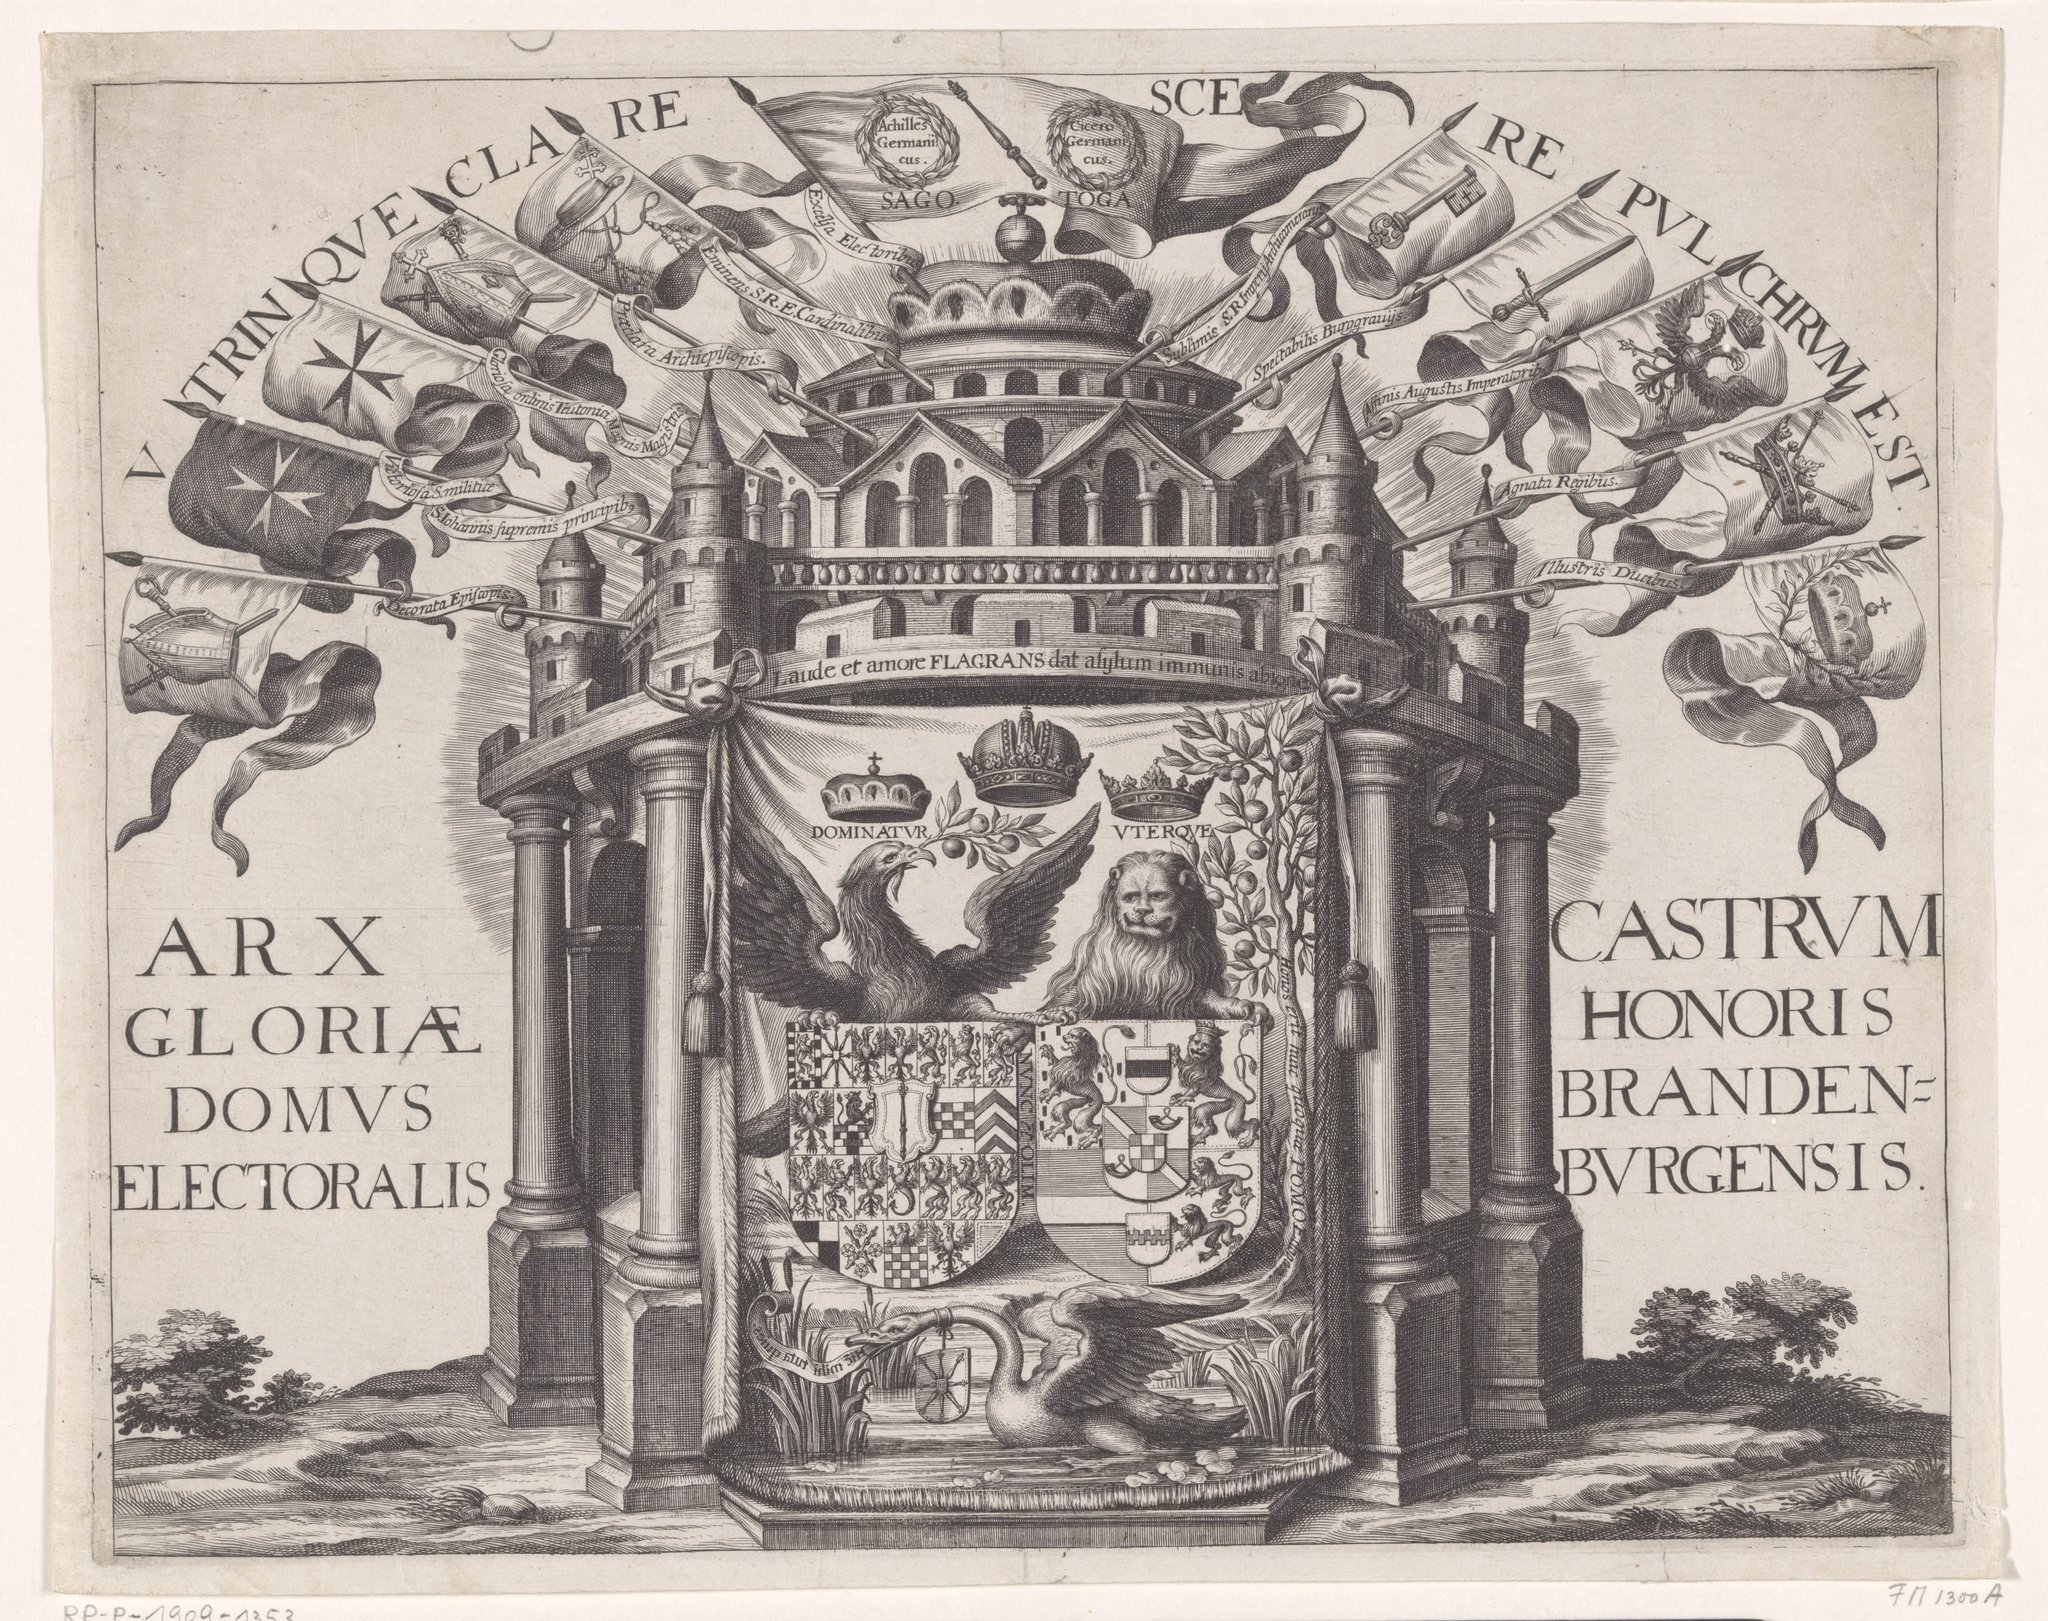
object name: print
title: Allegorie op de eendracht tussen Brandenburg en Nassau, ca. 1615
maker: Anonymous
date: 1614-1616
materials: paper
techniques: engraving, etching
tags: the hague, maurice (prince of orange), triumphal arch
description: Allegorie op de eendracht tussen Brandenburg en Nassau in de Gulik-Kleefse kwestie, ca. 1615. Triomfpoort waarvoor een doek hangt met het wapen van Brandenburg met een adelaar en een leeuw met het wapen van Maurits. Op de voorgrond een zwaan met om de hals het wapen van Kleef. Op de poort een paleis of gebouw waaruit vaandels met symbolen zijn gestoken. In het midden een vaandel met scepter en lauwerkransen van Achilles Germanicus en Cicero Germanicus. Met opschriften in het Latijn.